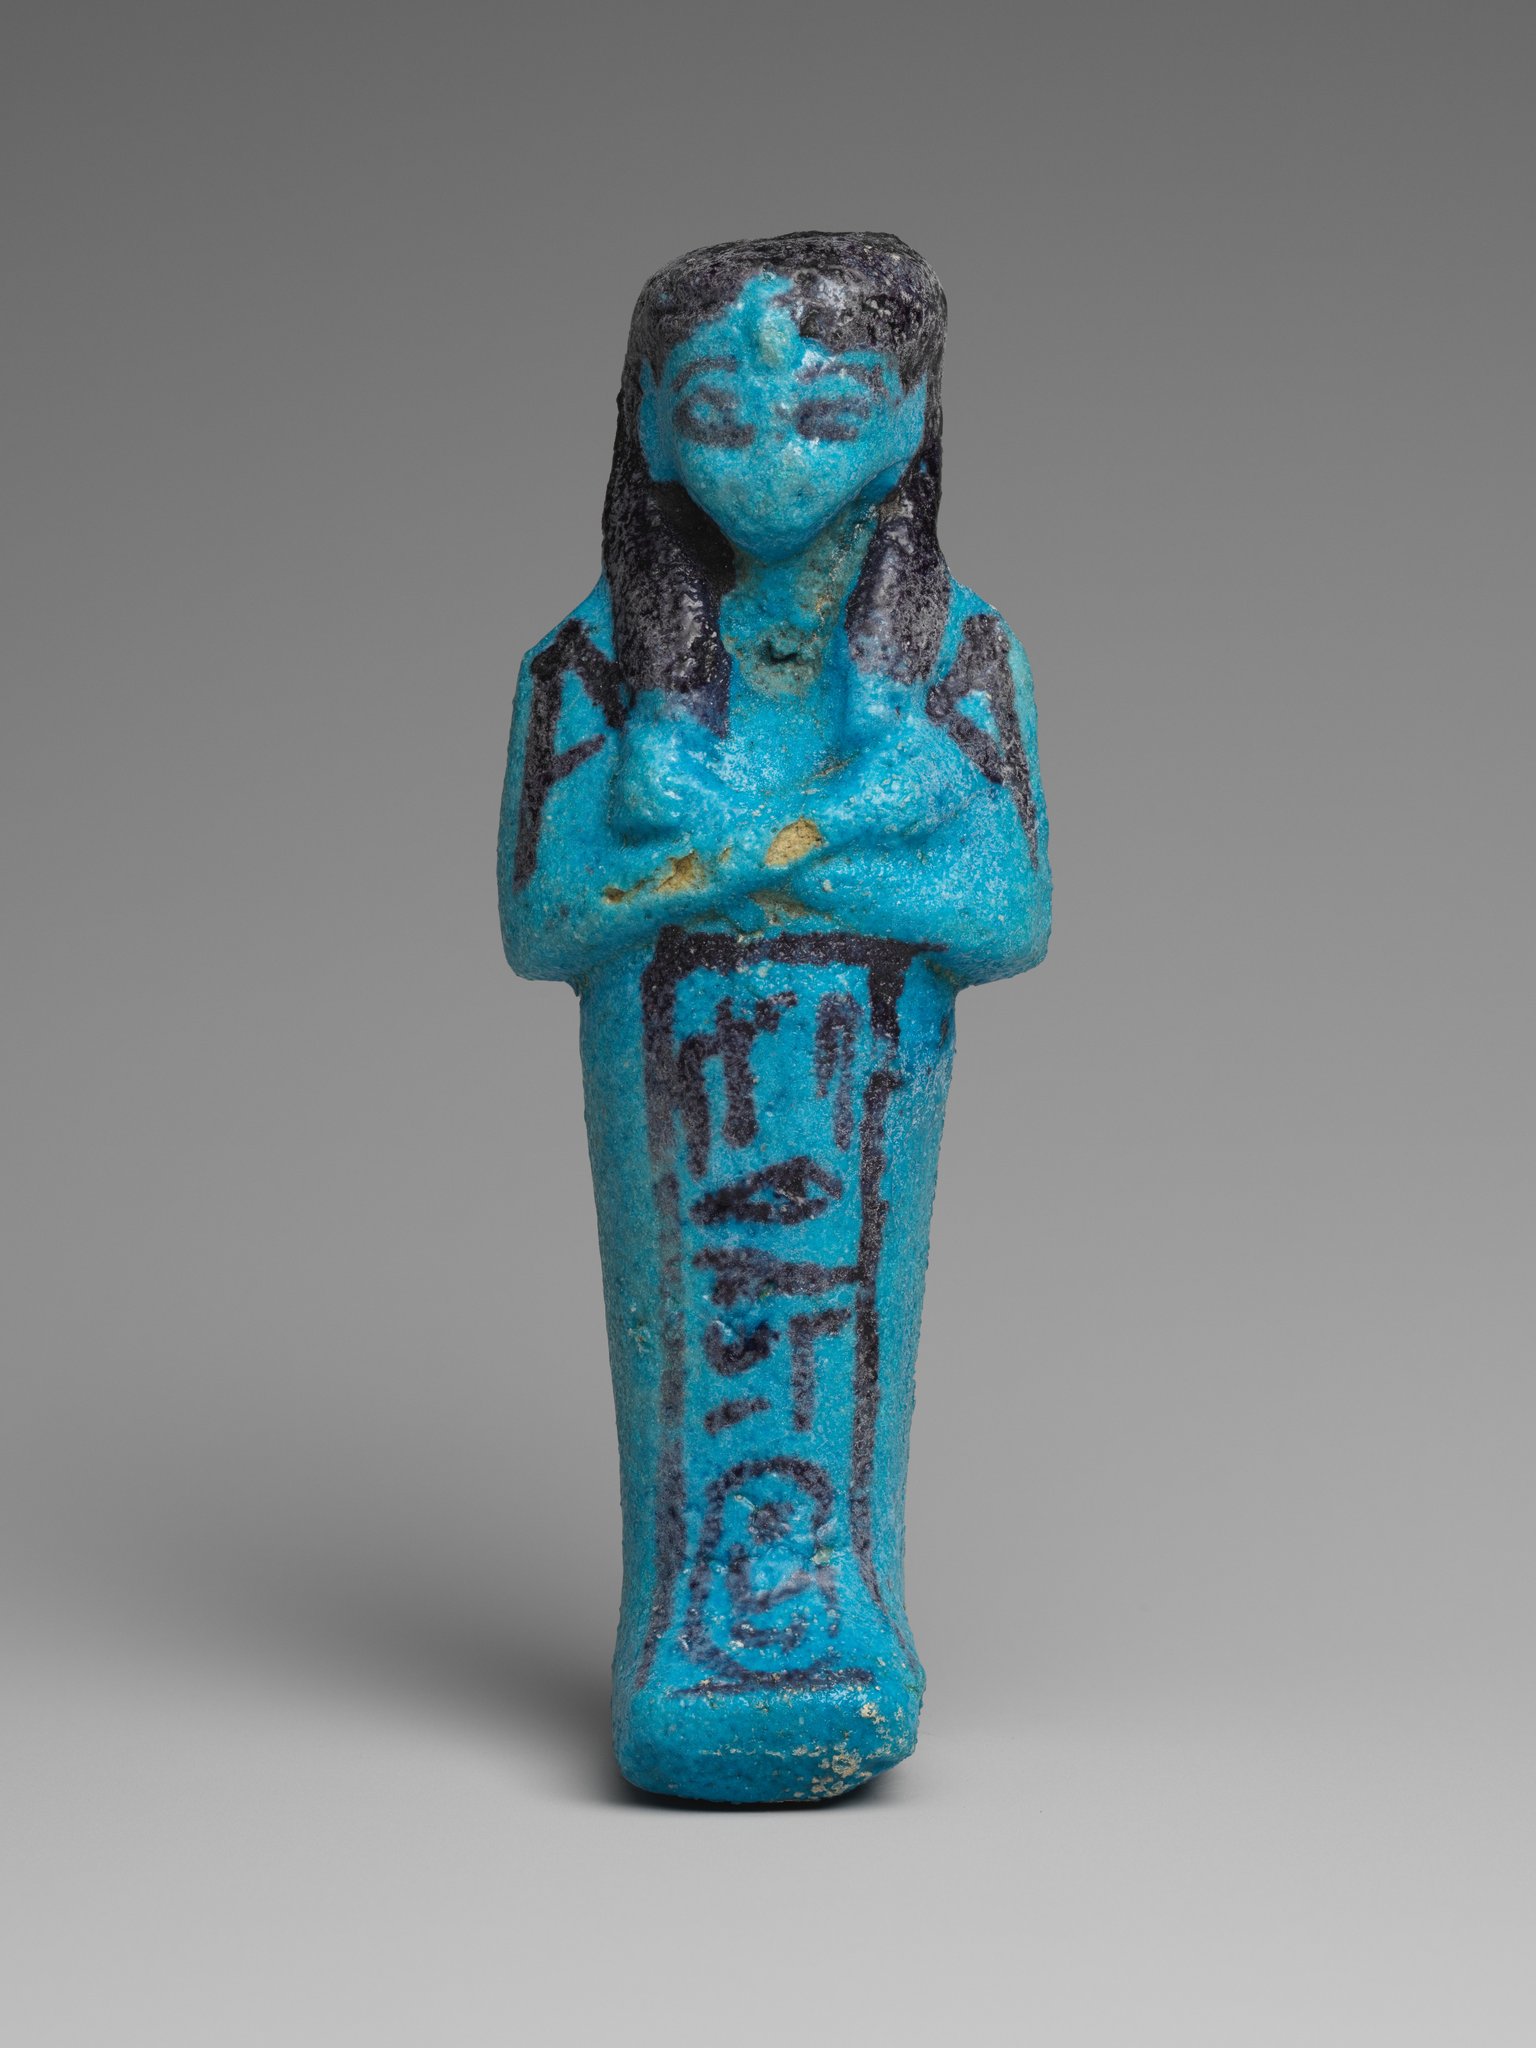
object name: shabti, god's wife maatkare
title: Shabti of the God's Wife Maatkare, daughter of Painedjem I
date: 1070-1032 BCE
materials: faience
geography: upper egypt, thebes